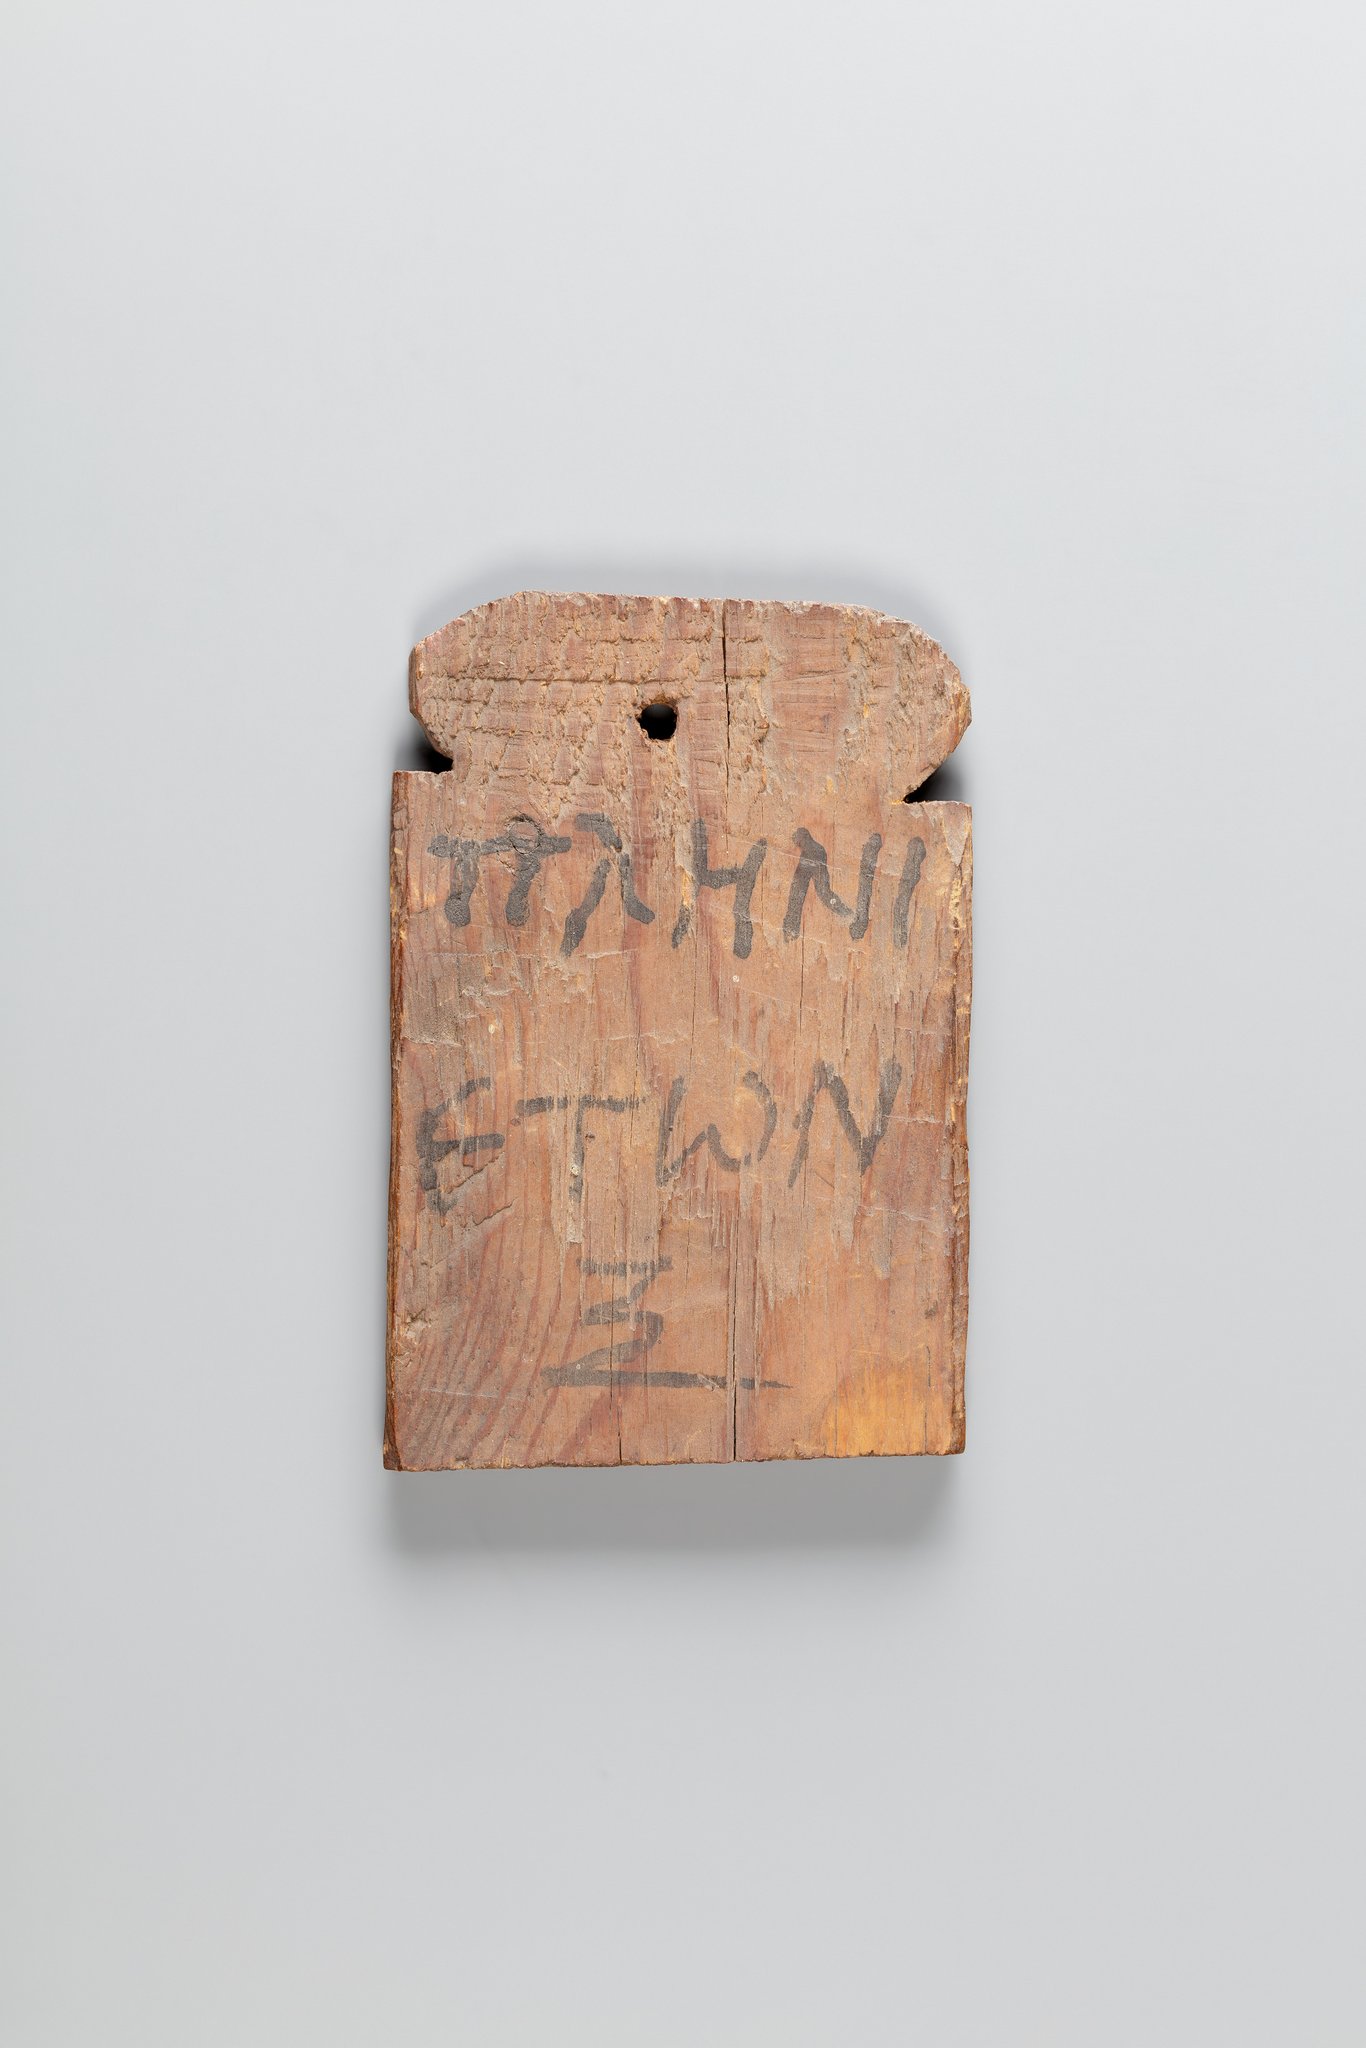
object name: mummy label, pleni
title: Mummy label of Pleni, age 60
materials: ink, wood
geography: upper egypt, thebes